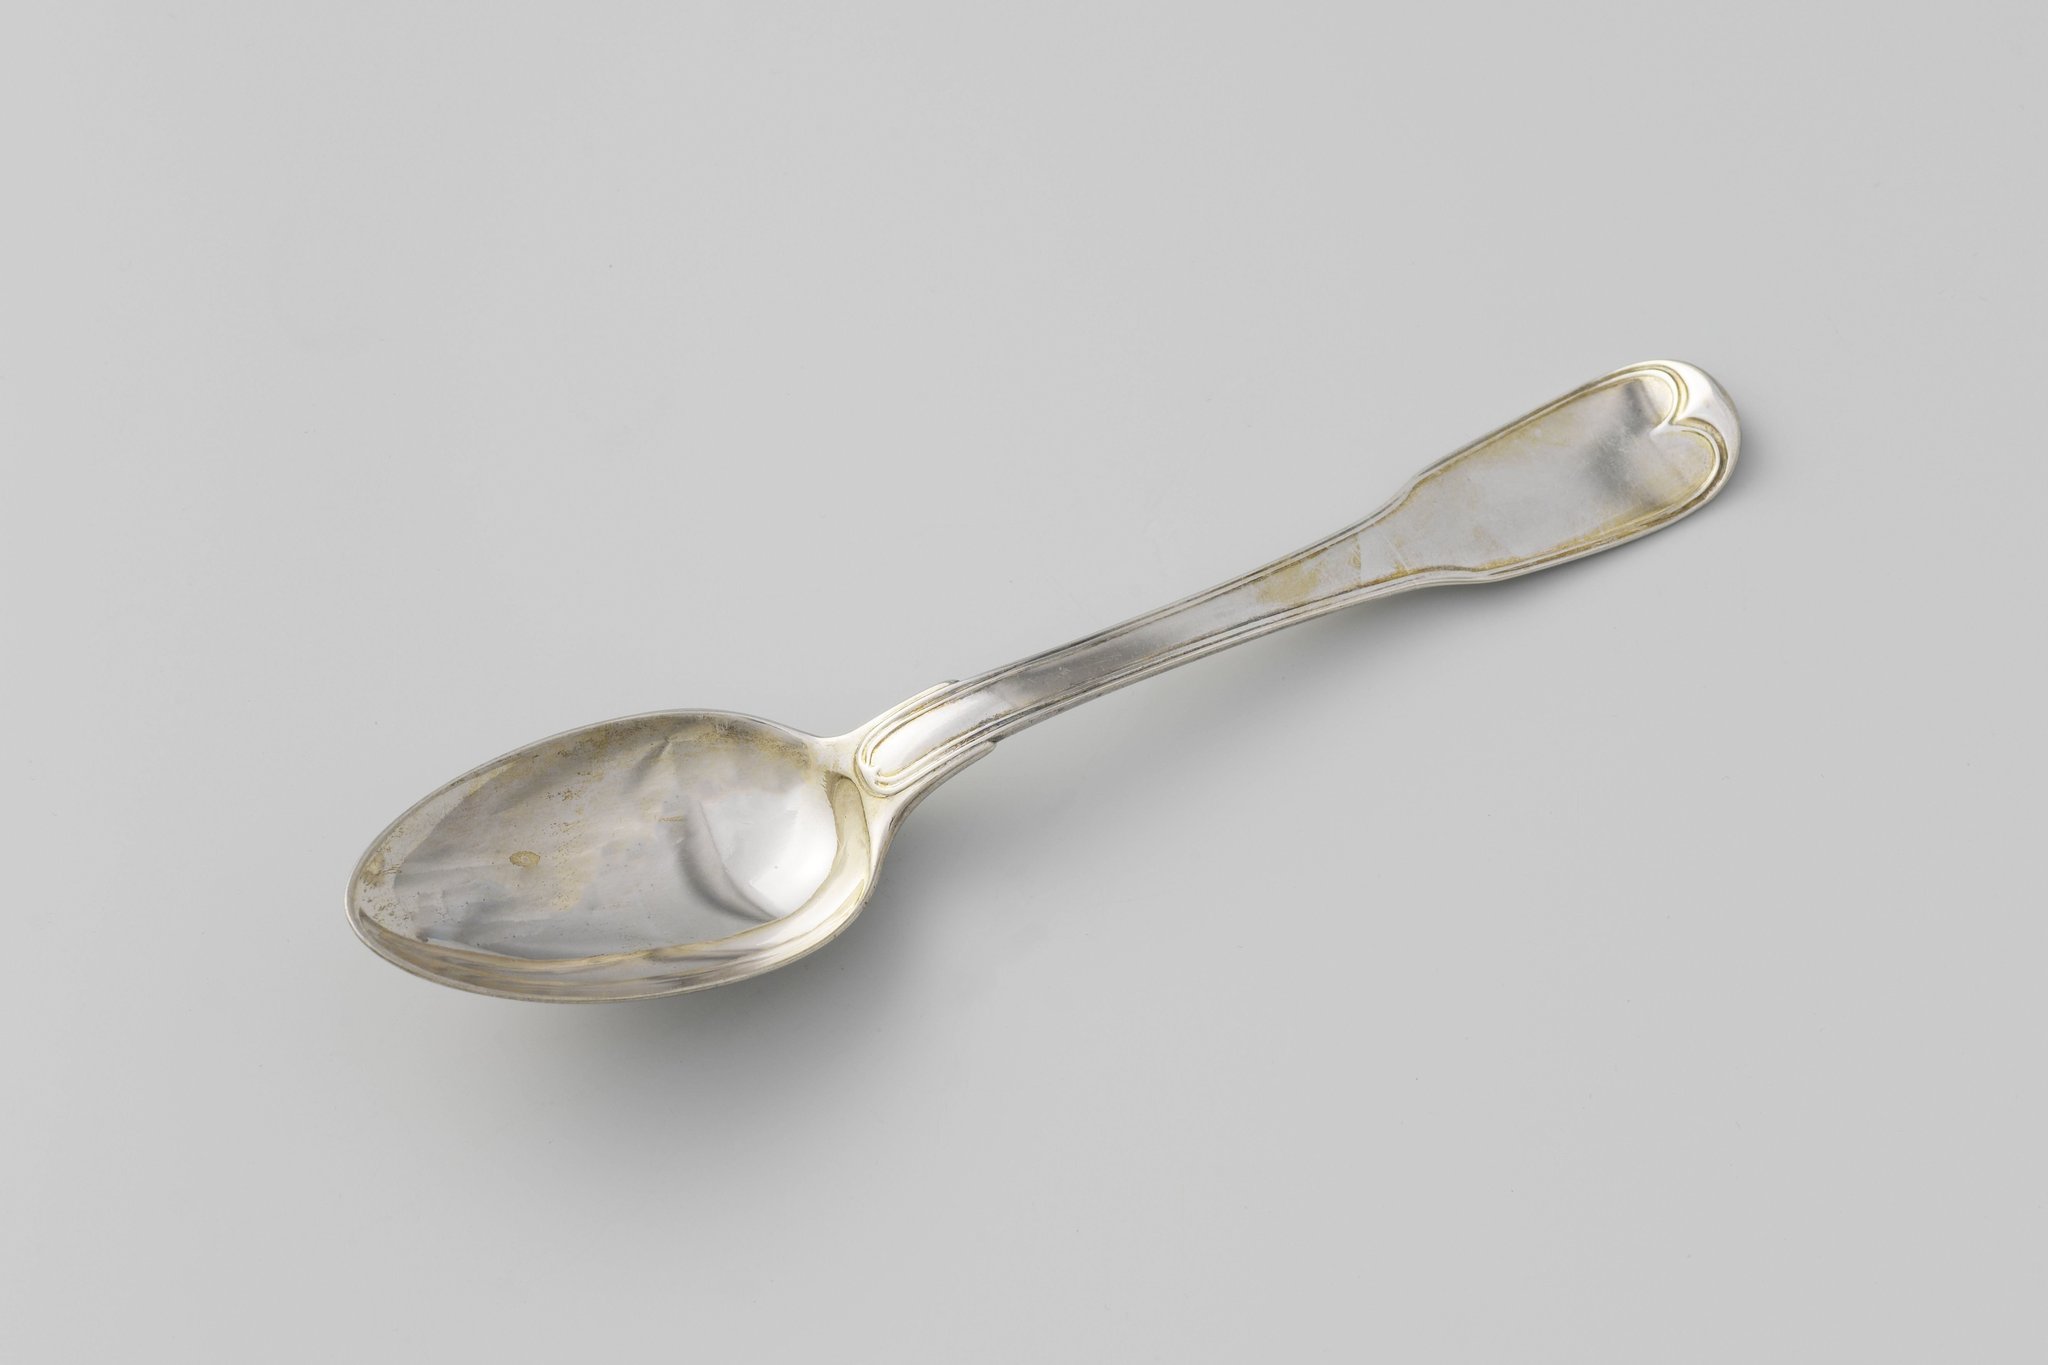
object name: spoon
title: Lepel met het helmteken Clifford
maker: roelof helweg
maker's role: silversmith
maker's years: 1758-1843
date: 1806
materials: silver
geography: amsterdam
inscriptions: maker's mark: ‘RH in ovaal’, alloy mark: ‘Hollandse leeuw’, date letter: ‘X (=1806)’, town mark: ‘Amsterdam’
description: De eivormige bak van de lepel is aan zowel boven- als onderzijde door middel van enkel lof verbonden met de platte, gebogen steel, die zich verbreedt naar het spatelvormige uiteinde. Boven- en onderzijde van de steel worden omgeven door een dubbele filetrand, die bij het uiteinde ingezwenkt is. Op de onderzijde van de spatel is het helmteken Clifford gegraveerd.